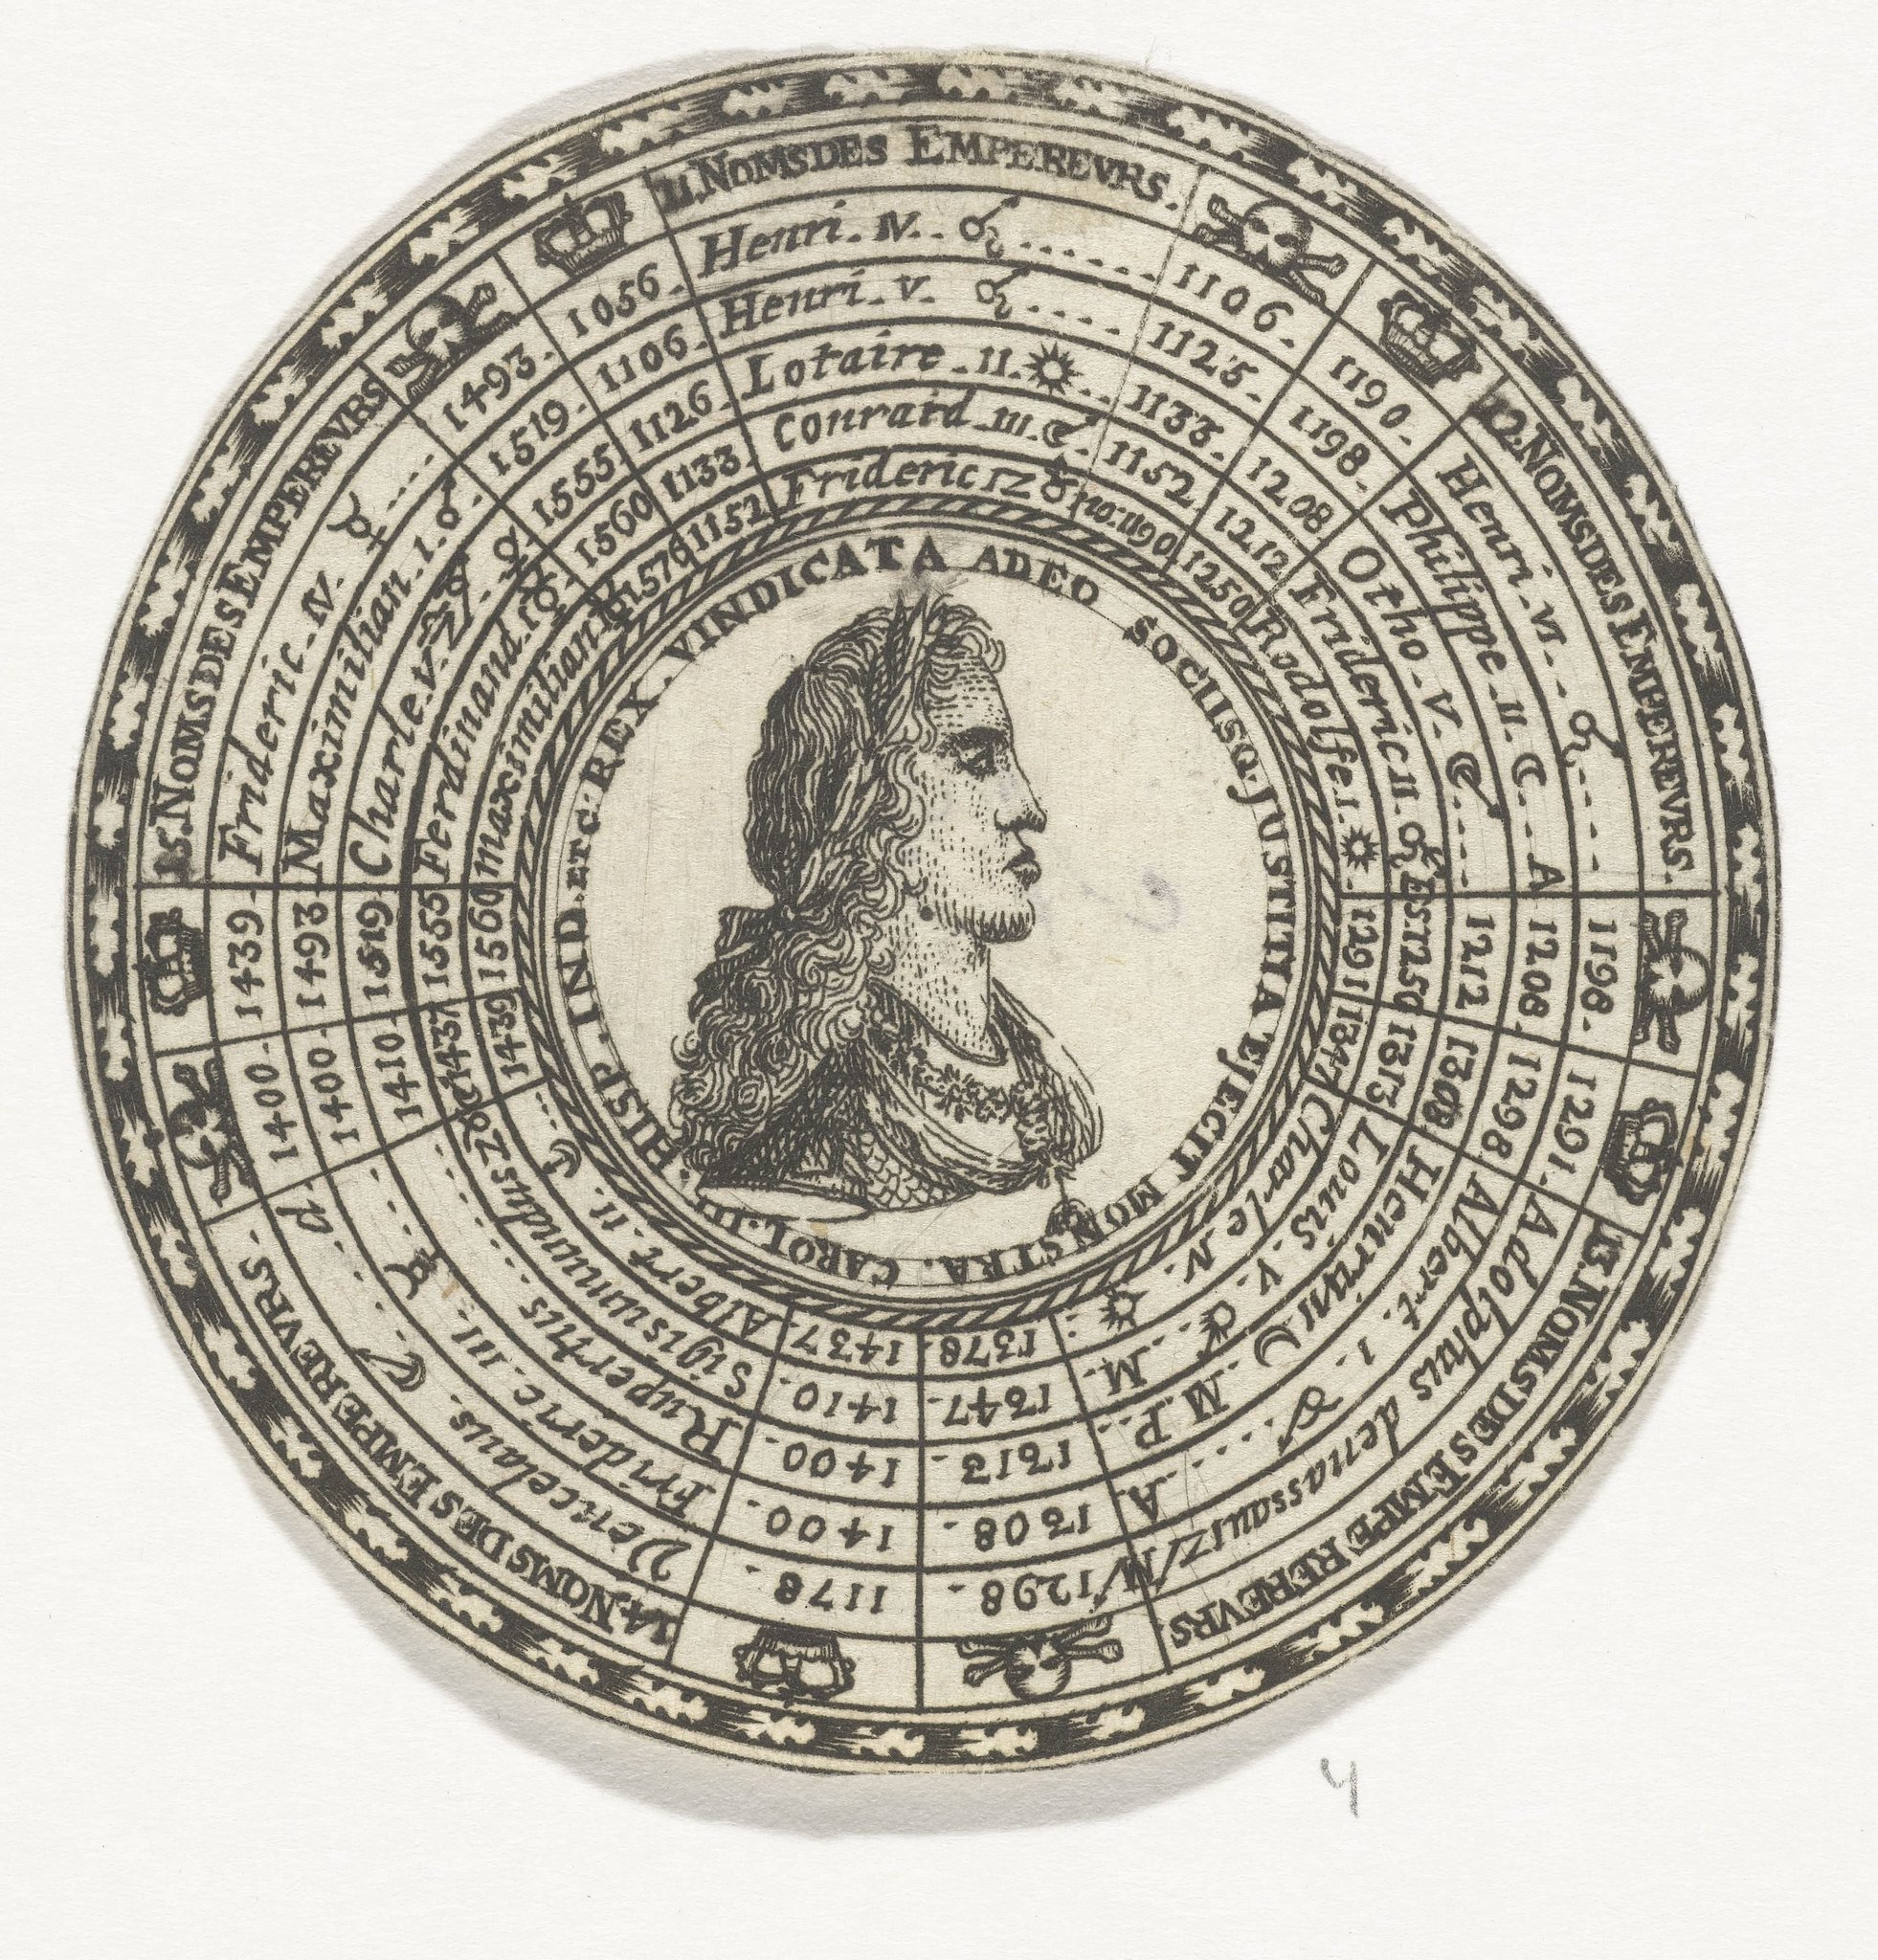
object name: print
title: Penning met het portret van Karel V en de namen van keizers van het Heilige Roomse Rijk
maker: Anonymous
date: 1712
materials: paper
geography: amsterdam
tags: emperor, seal (symbol of sovereignty)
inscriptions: number: ‘5’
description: Ontwerp van een ronde penning met, in zes concentrische cirkels, de namen van keizers van het Heilige Roomse Rijk en hun regeringsjaren, beginnende bij keizer Hendrik IV en eindigend bij keizer Maximiliaan II. In het midden van de penning het portret van Karel V.